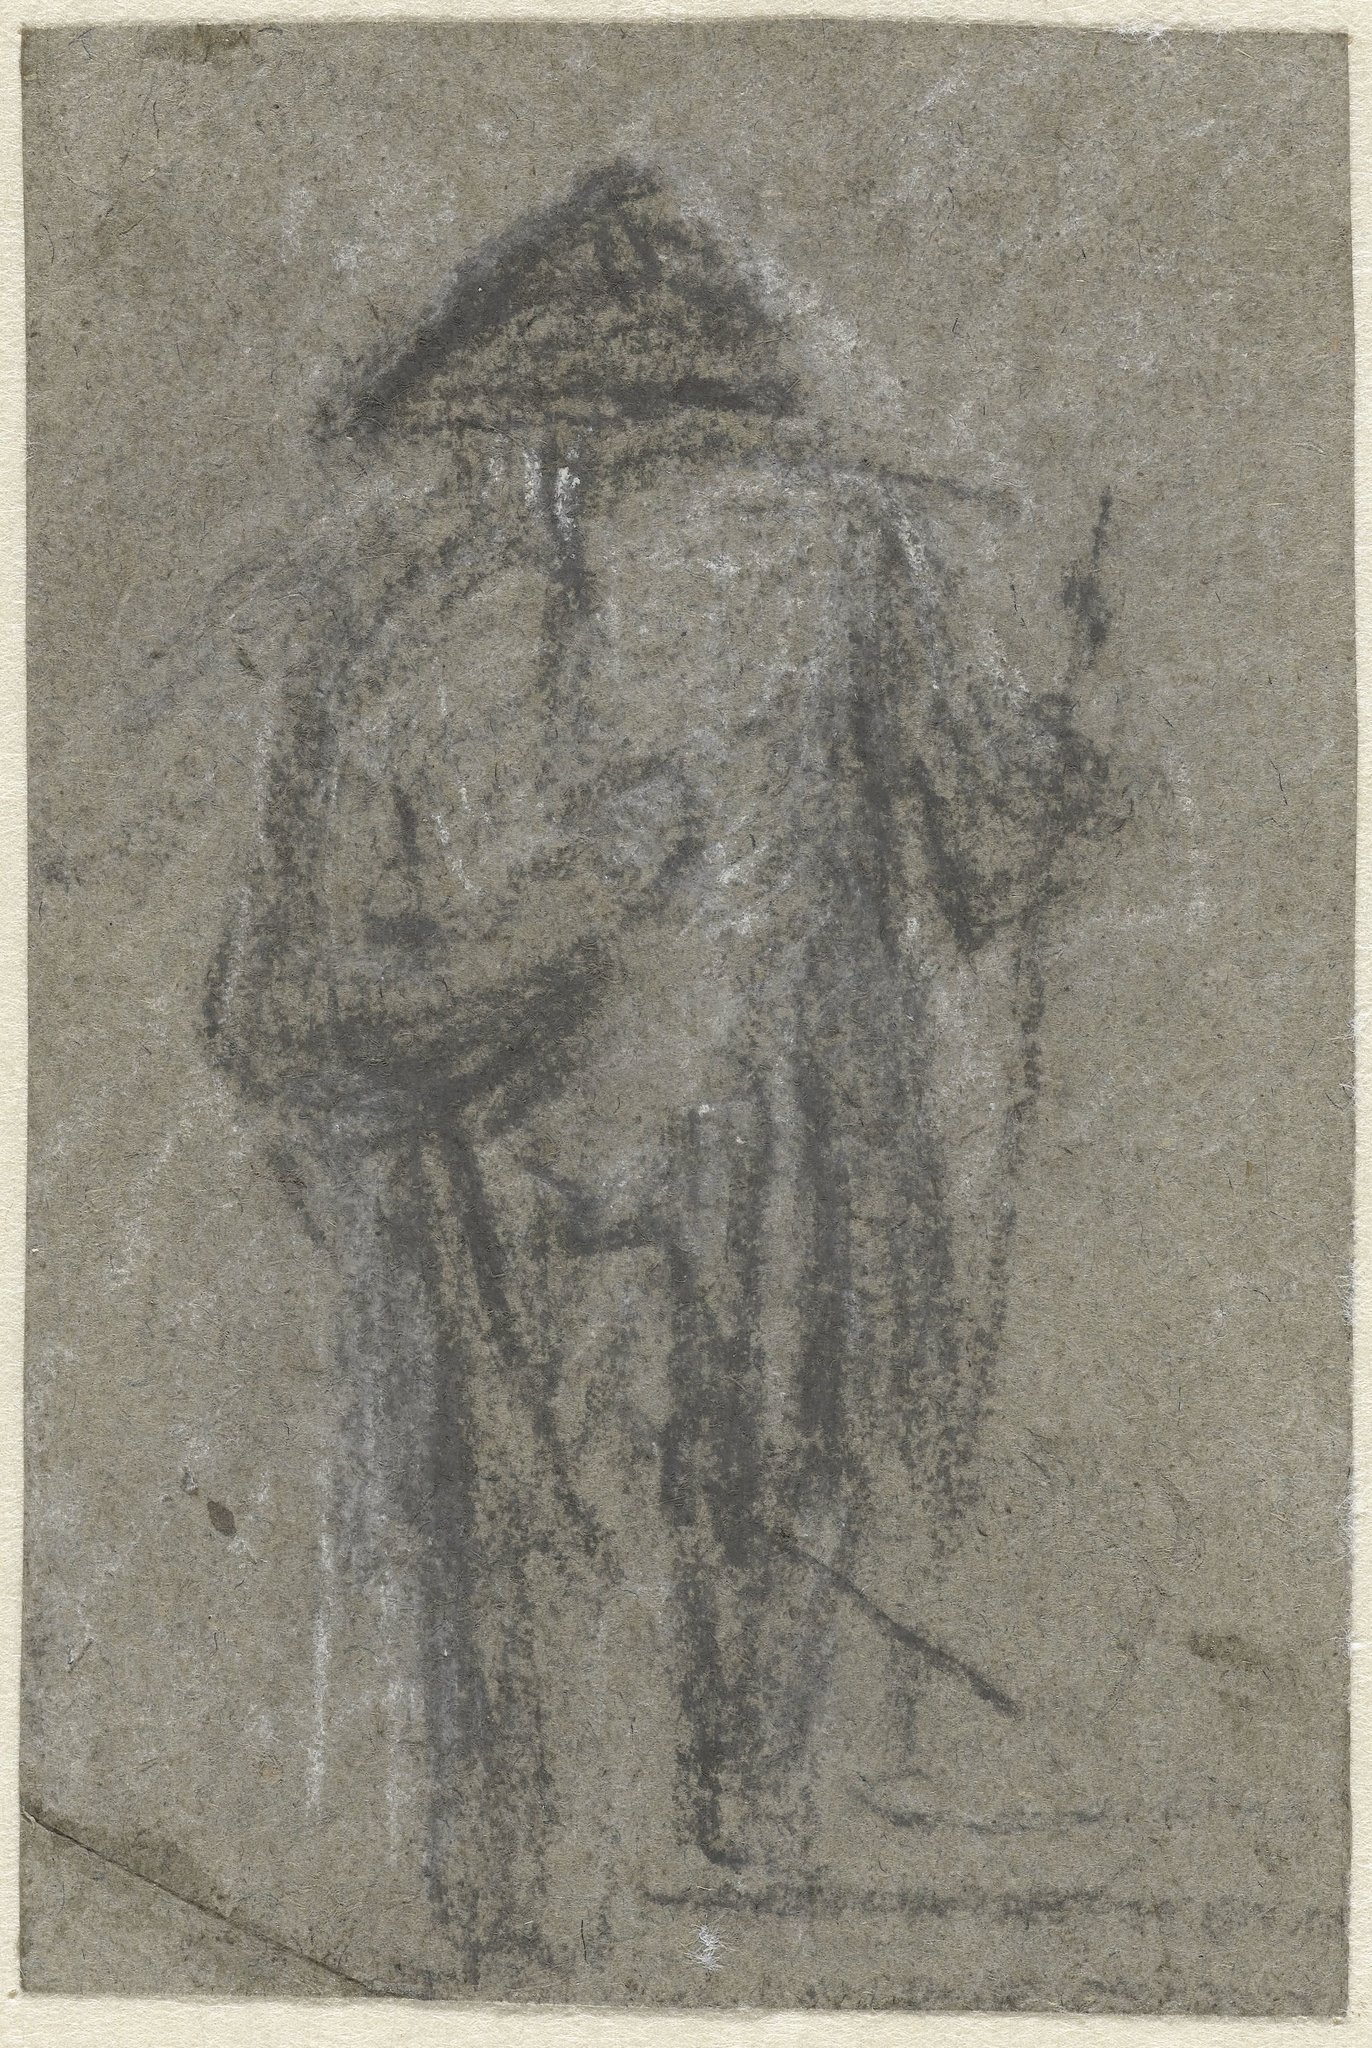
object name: drawing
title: Staande man met de hand op de rug, op de rug gezien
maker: simon andreas krausz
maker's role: draughtsman, print maker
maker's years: 1760-1825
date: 1770-1825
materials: chalk, paper